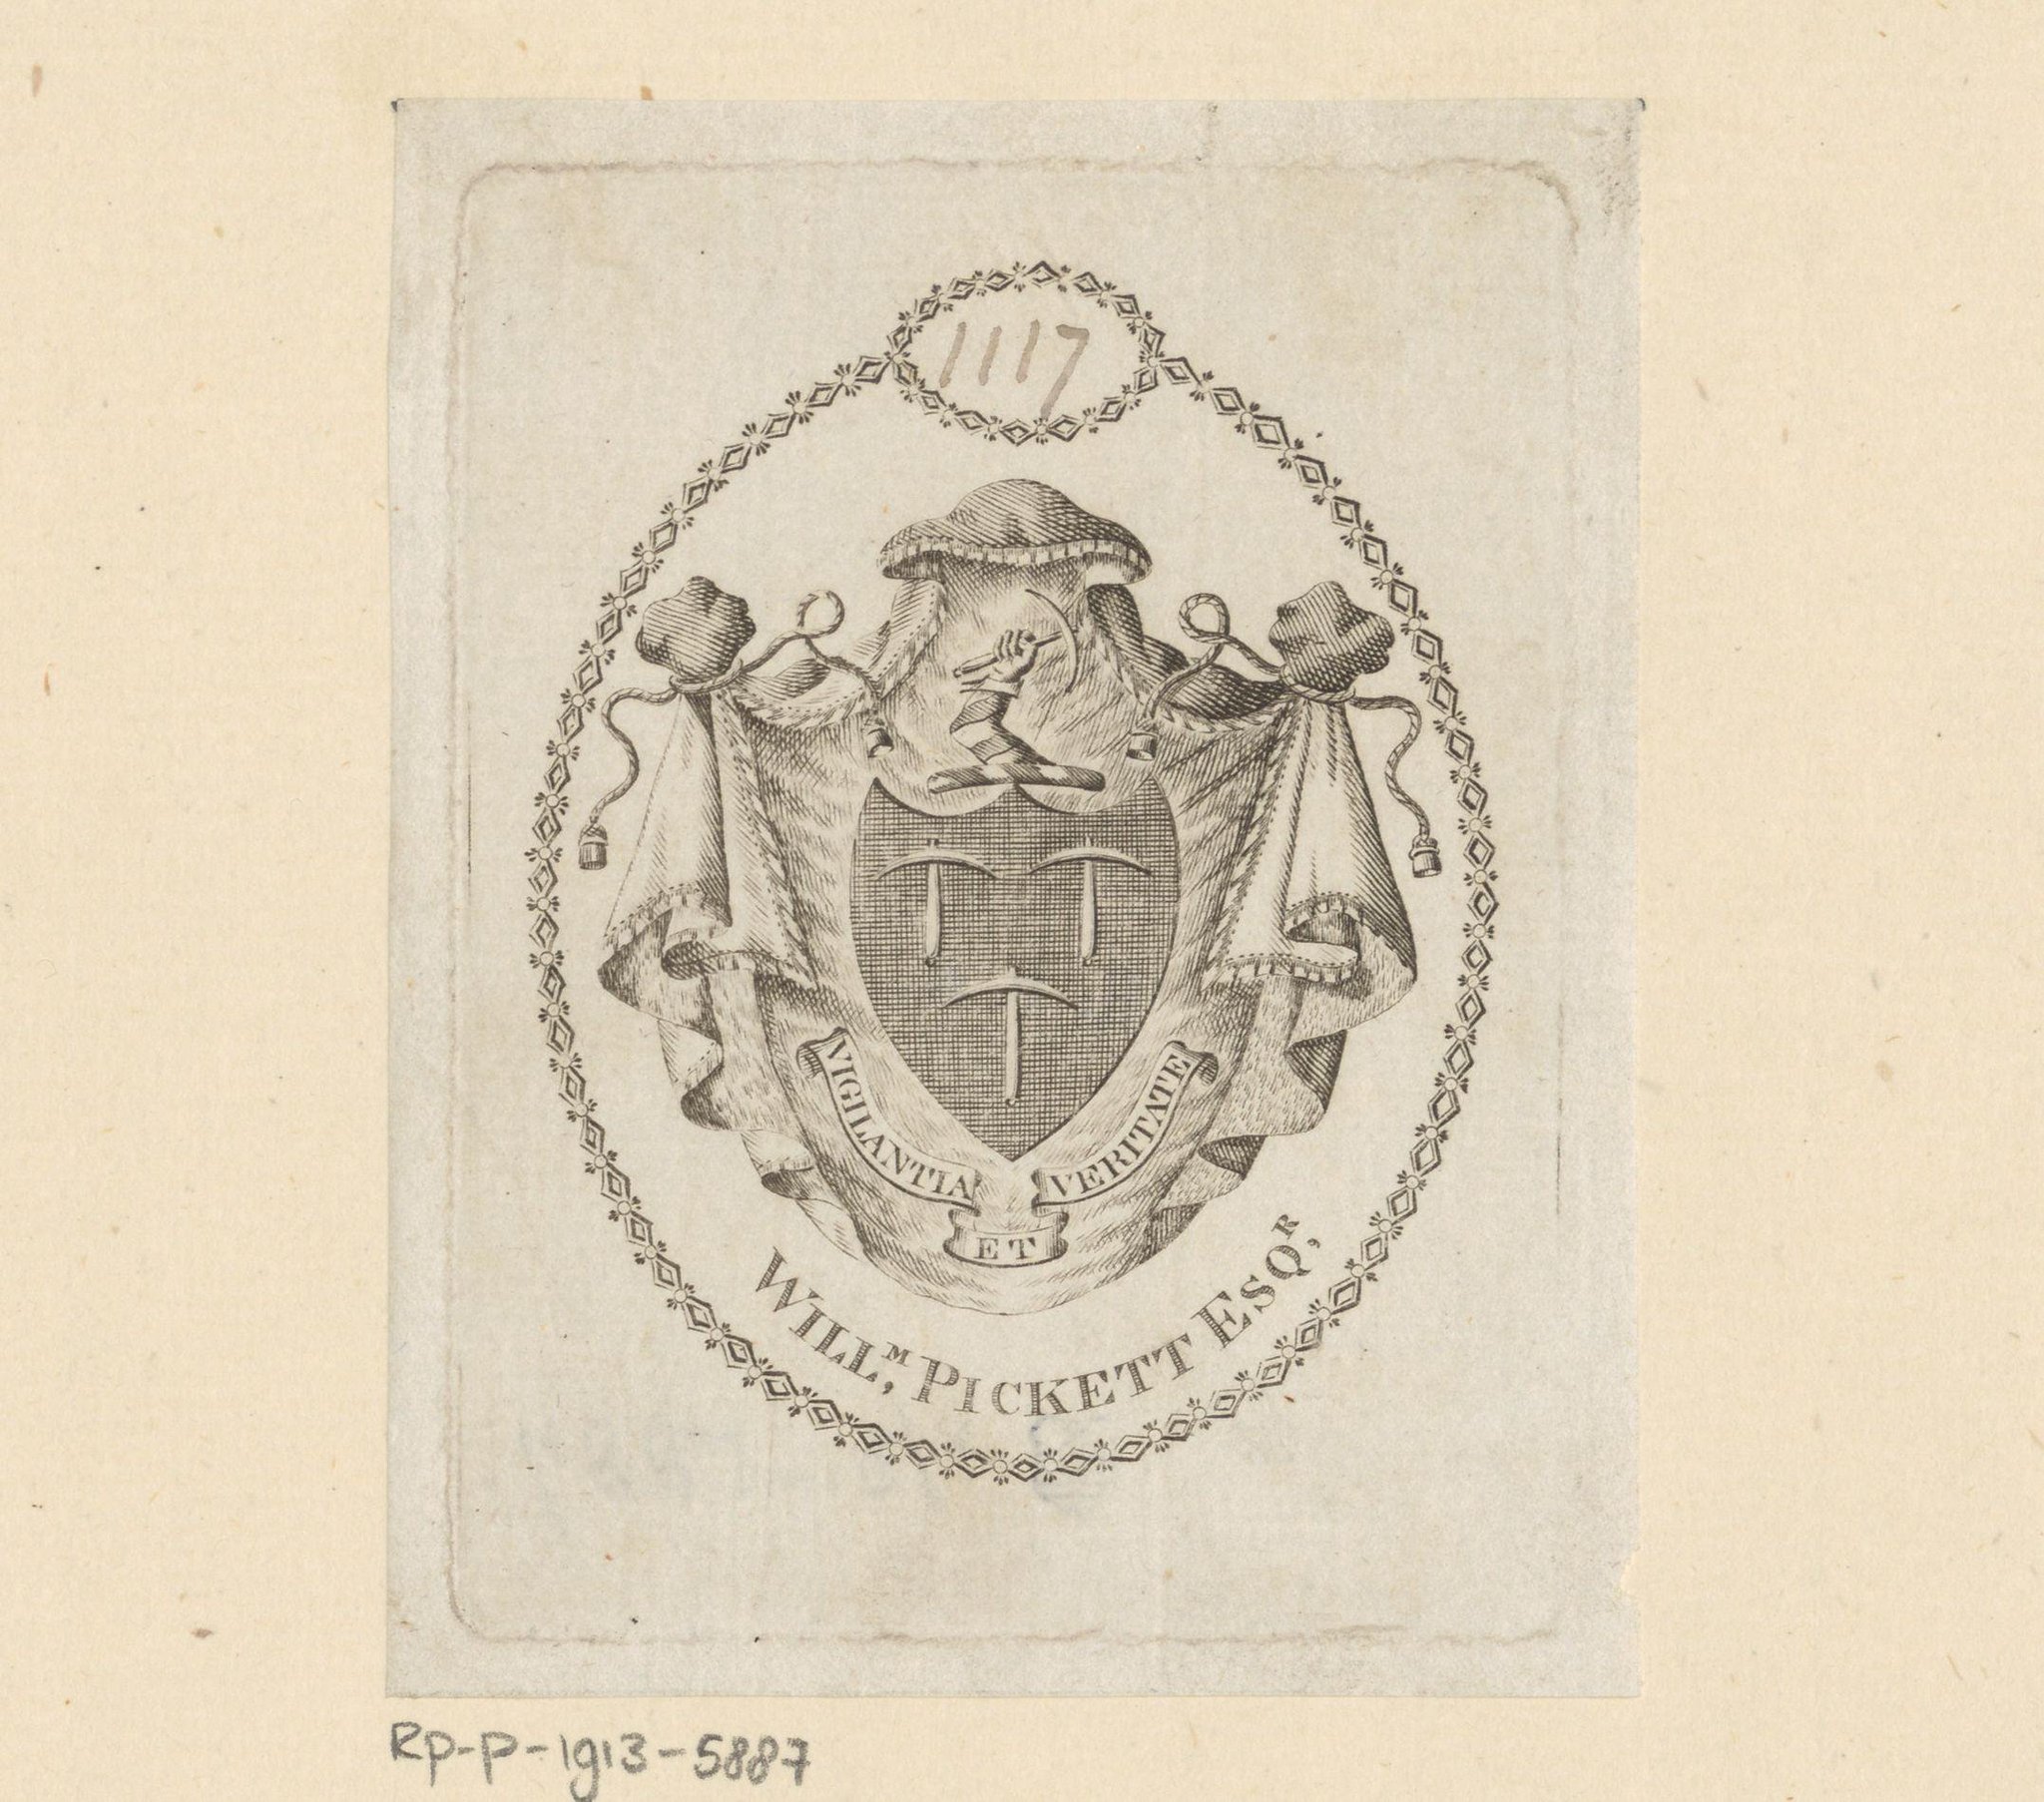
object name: bookplate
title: Ex libris van Willm. Pickett Esqr.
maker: Anonymous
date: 1750-1849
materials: paper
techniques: engraving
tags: armorial bearing, heraldry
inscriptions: number: ‘1117’, collector's mark: Lugt 2760, collector's mark: Lugt 2233